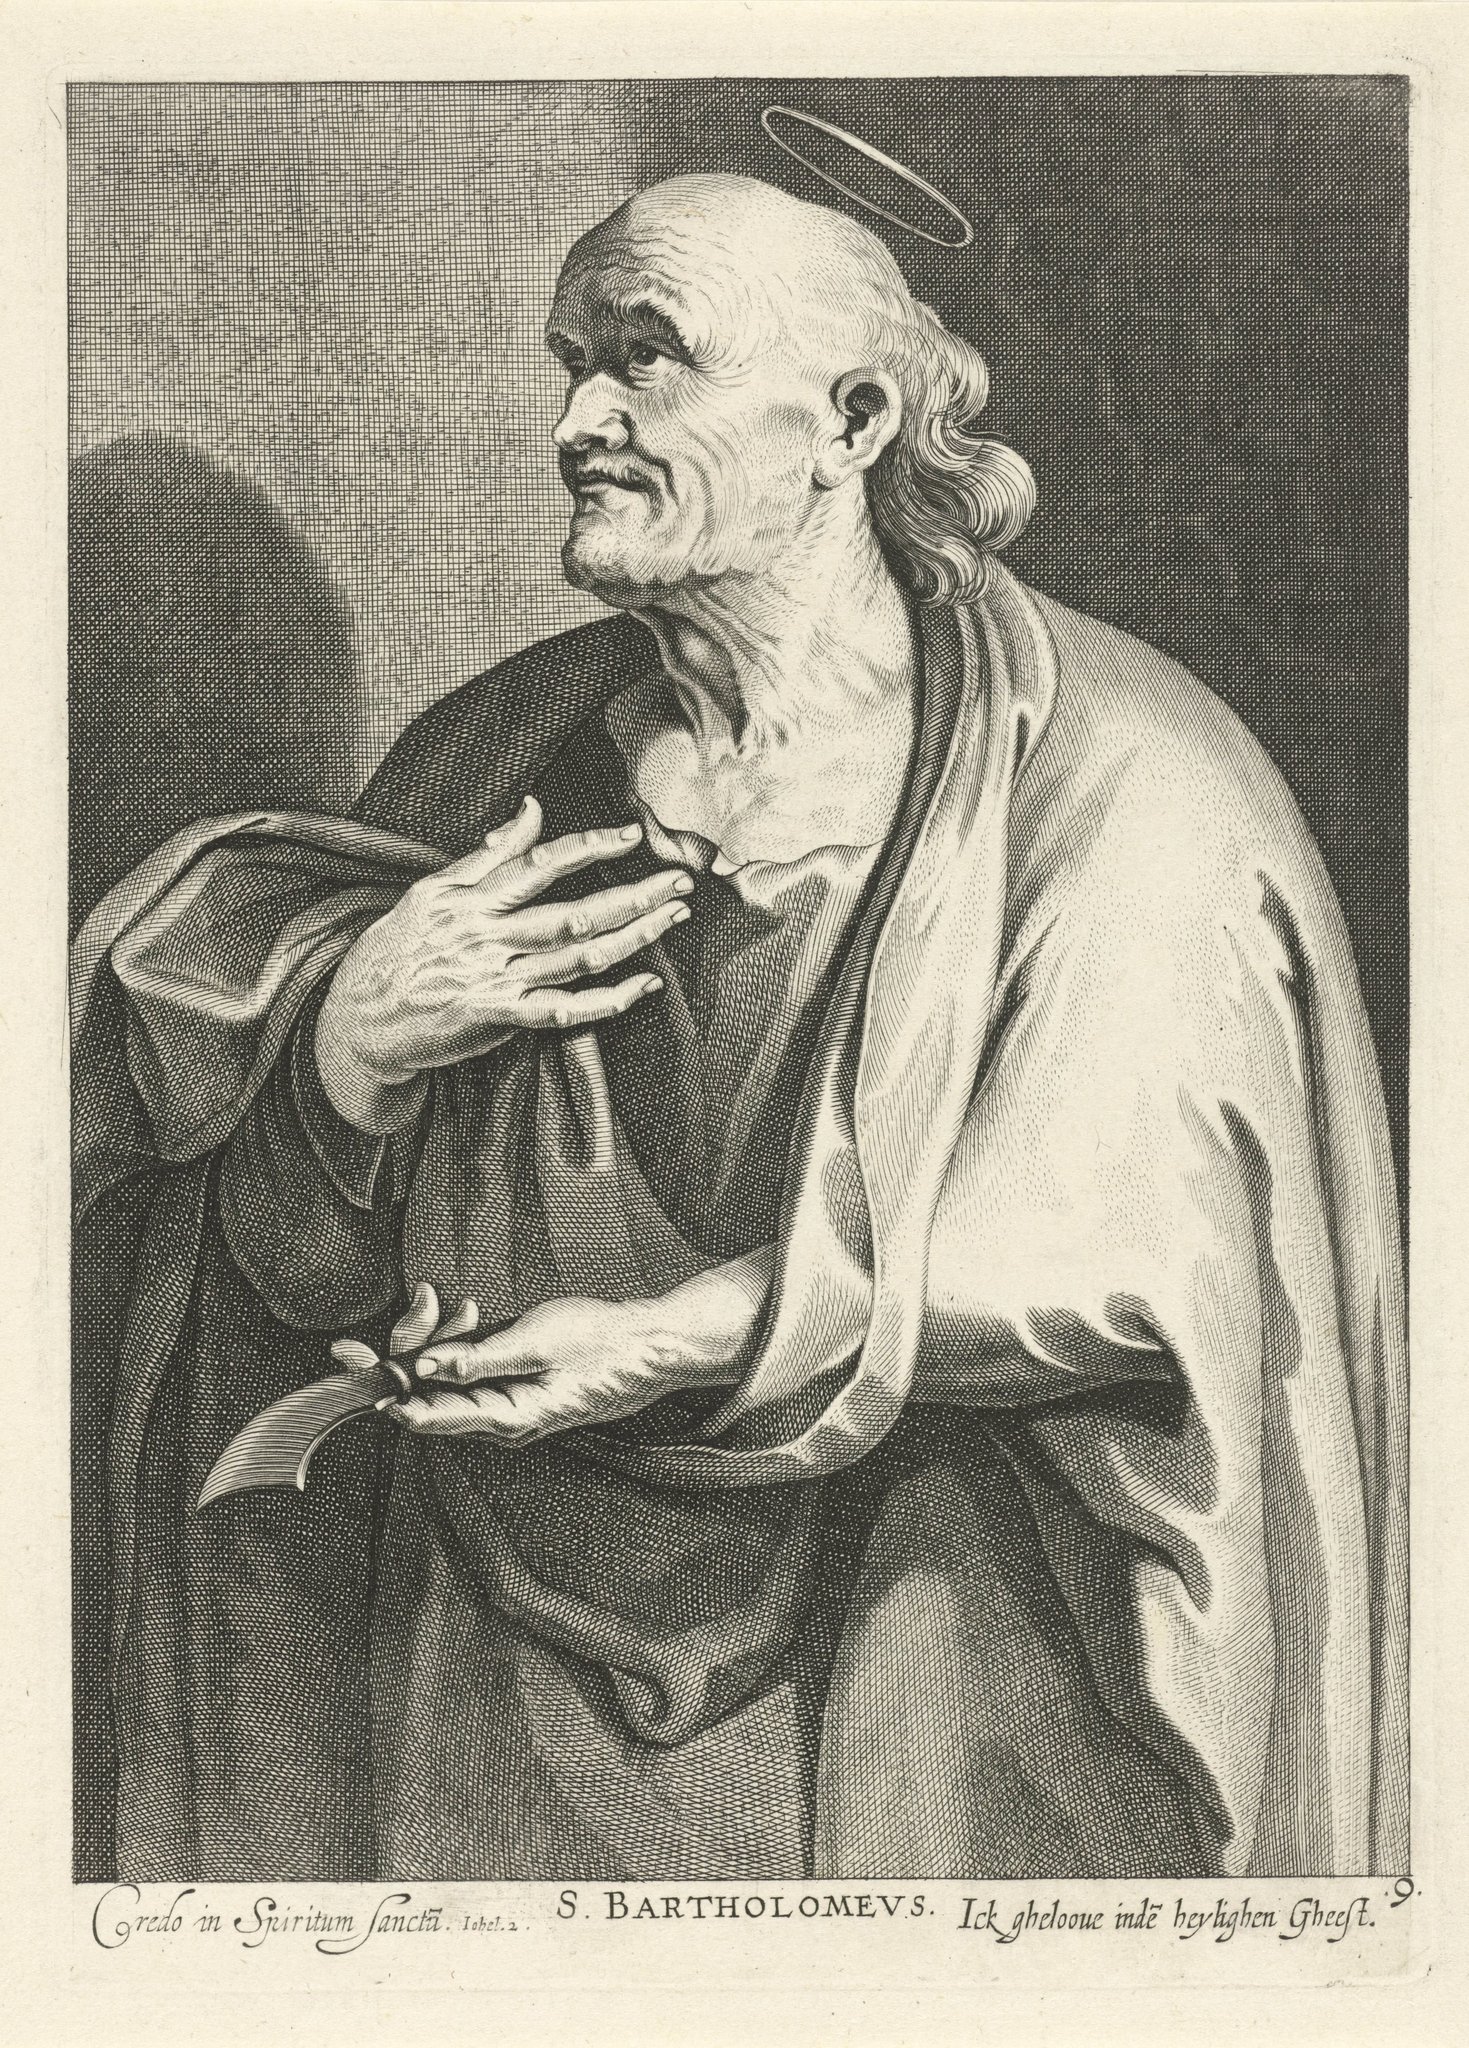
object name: print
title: Apostel Bartholomeus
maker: nicolaes ryckmans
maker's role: print maker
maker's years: 1595-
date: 1616-1636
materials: paper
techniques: engraving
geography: southern netherlands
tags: the apostle bartholomew; possible attributes: book, devil or dragon at feet, knife, scroll, flayed skin, staff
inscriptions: collector's mark: Lugt 240